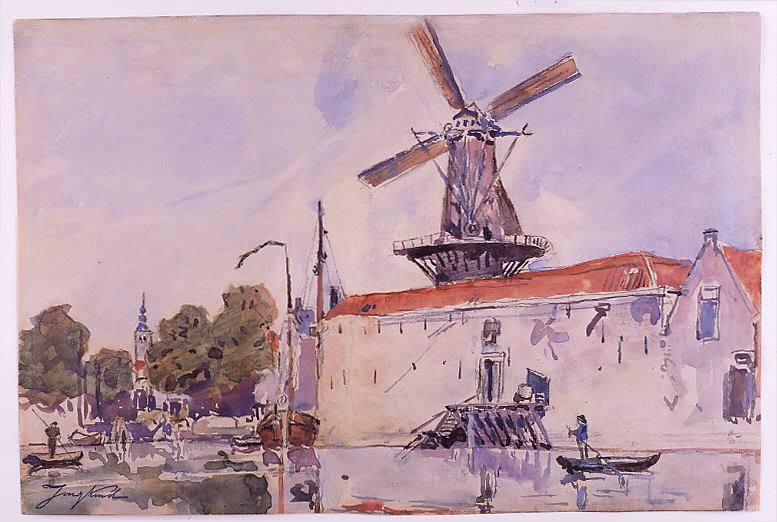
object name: drawing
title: View of Rotterdam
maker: johan barthold jongkind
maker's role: artist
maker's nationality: dutch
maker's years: 1819-1891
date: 1867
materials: watercolor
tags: windmills,boats